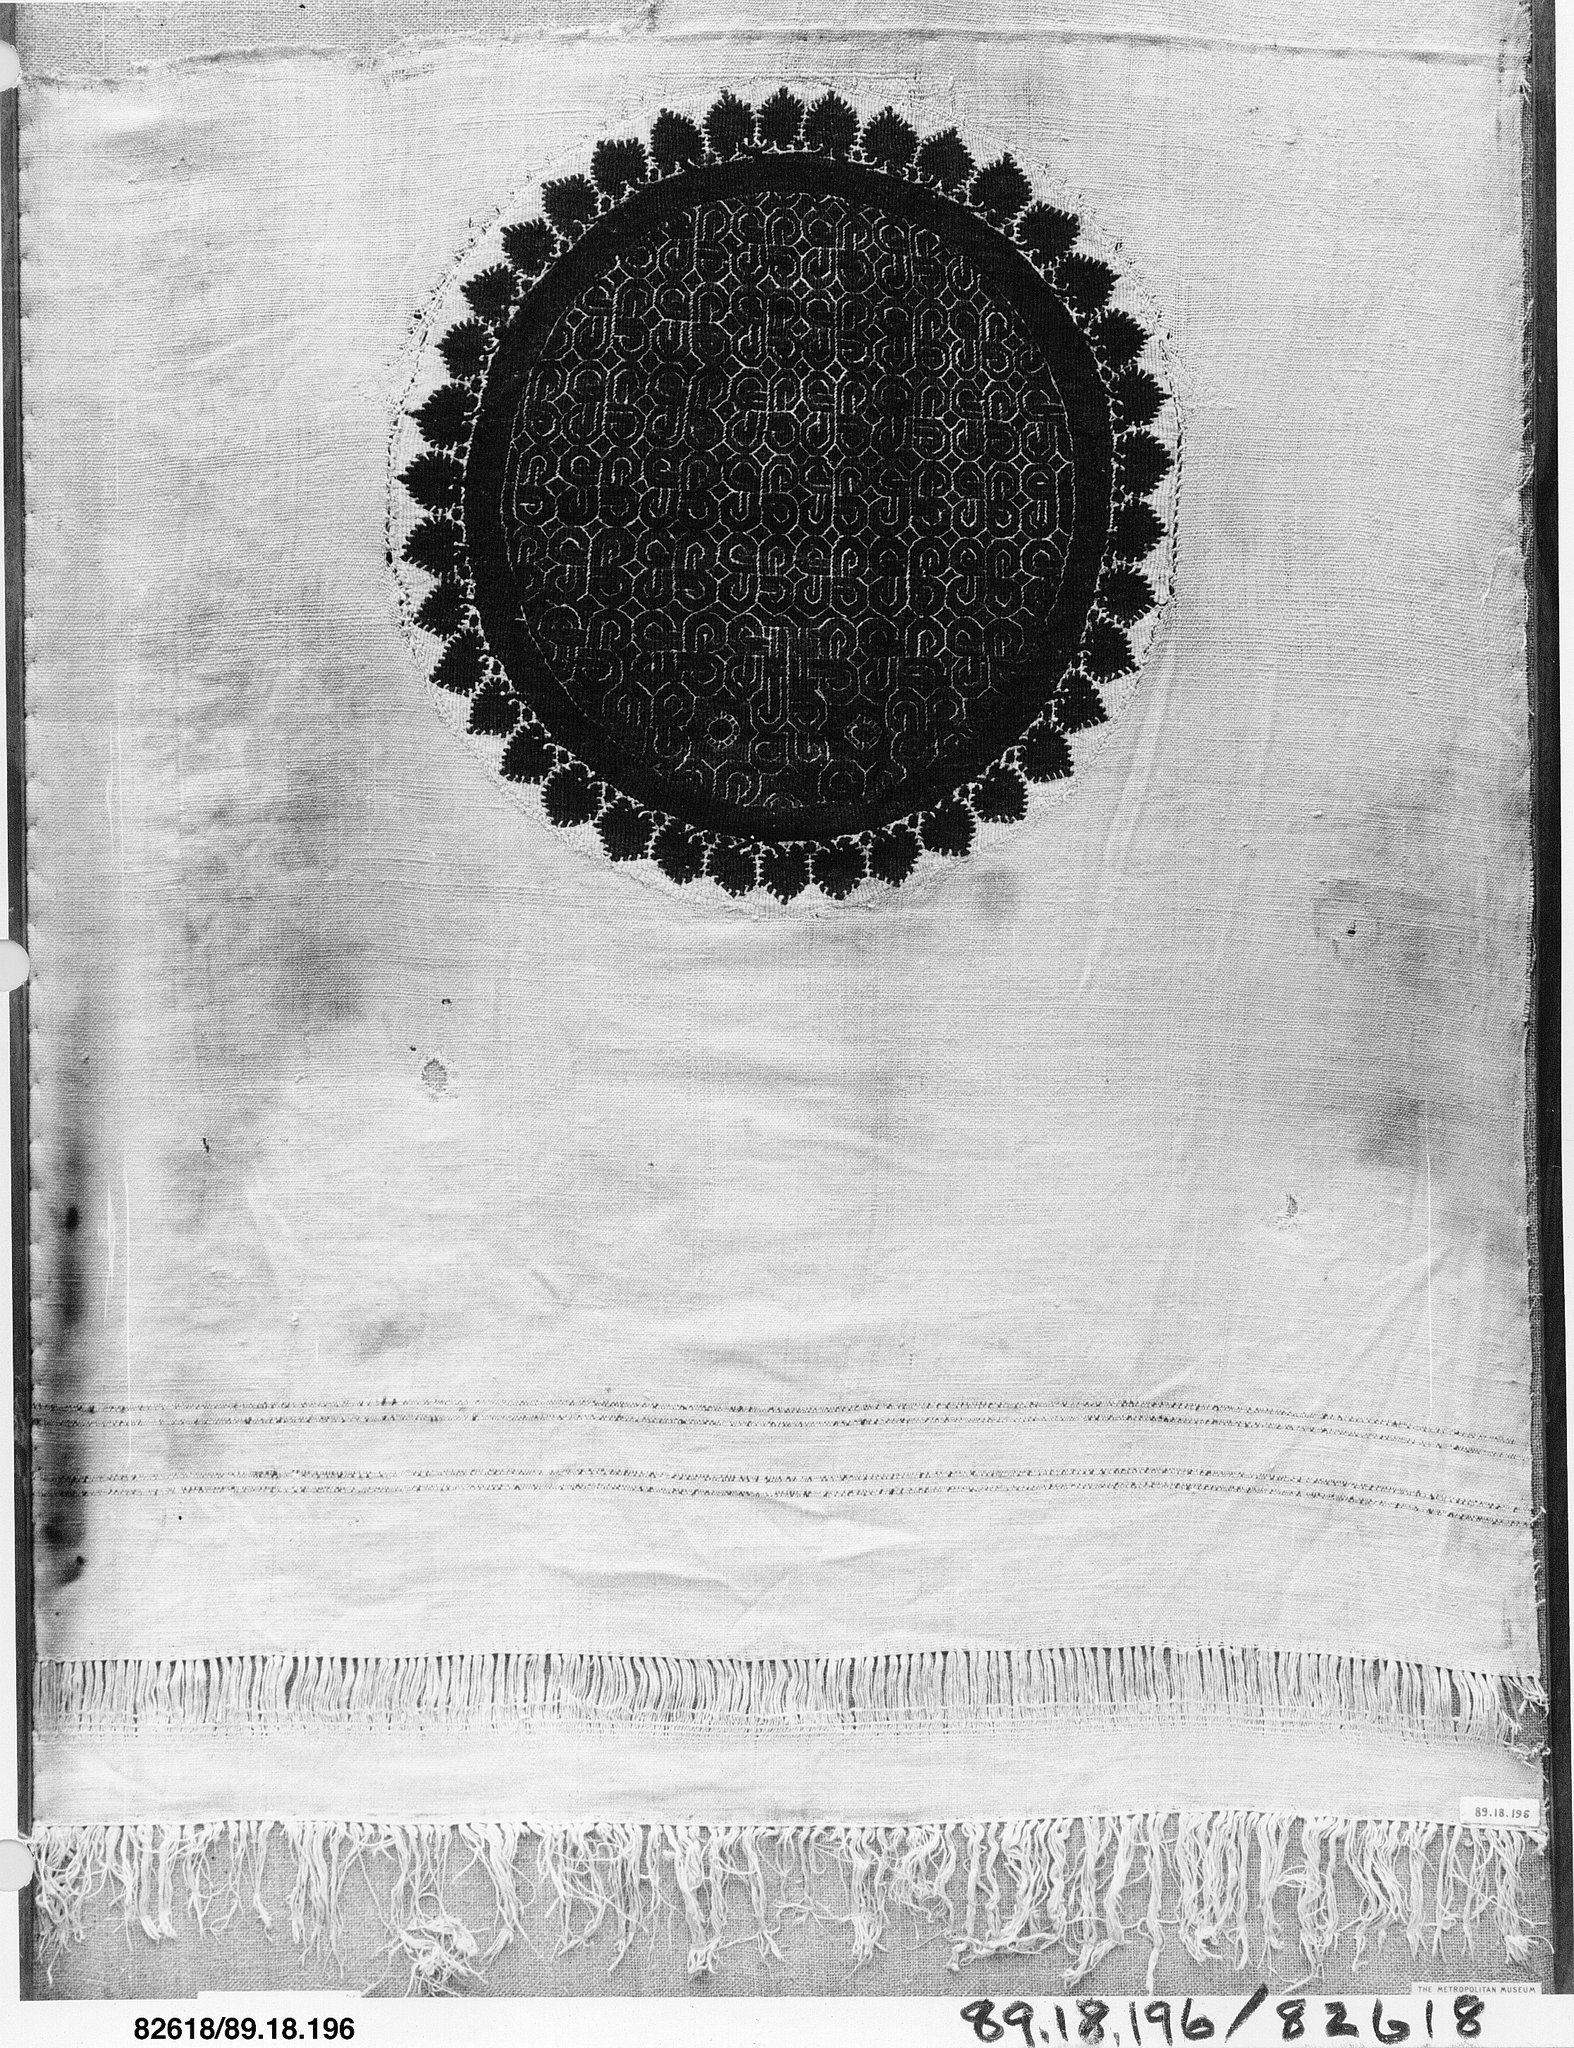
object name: textile fragment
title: Fragment with an Interlace Medalion Bordered by Vine Leaves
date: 201-600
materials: linen, wool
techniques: weave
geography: egypt